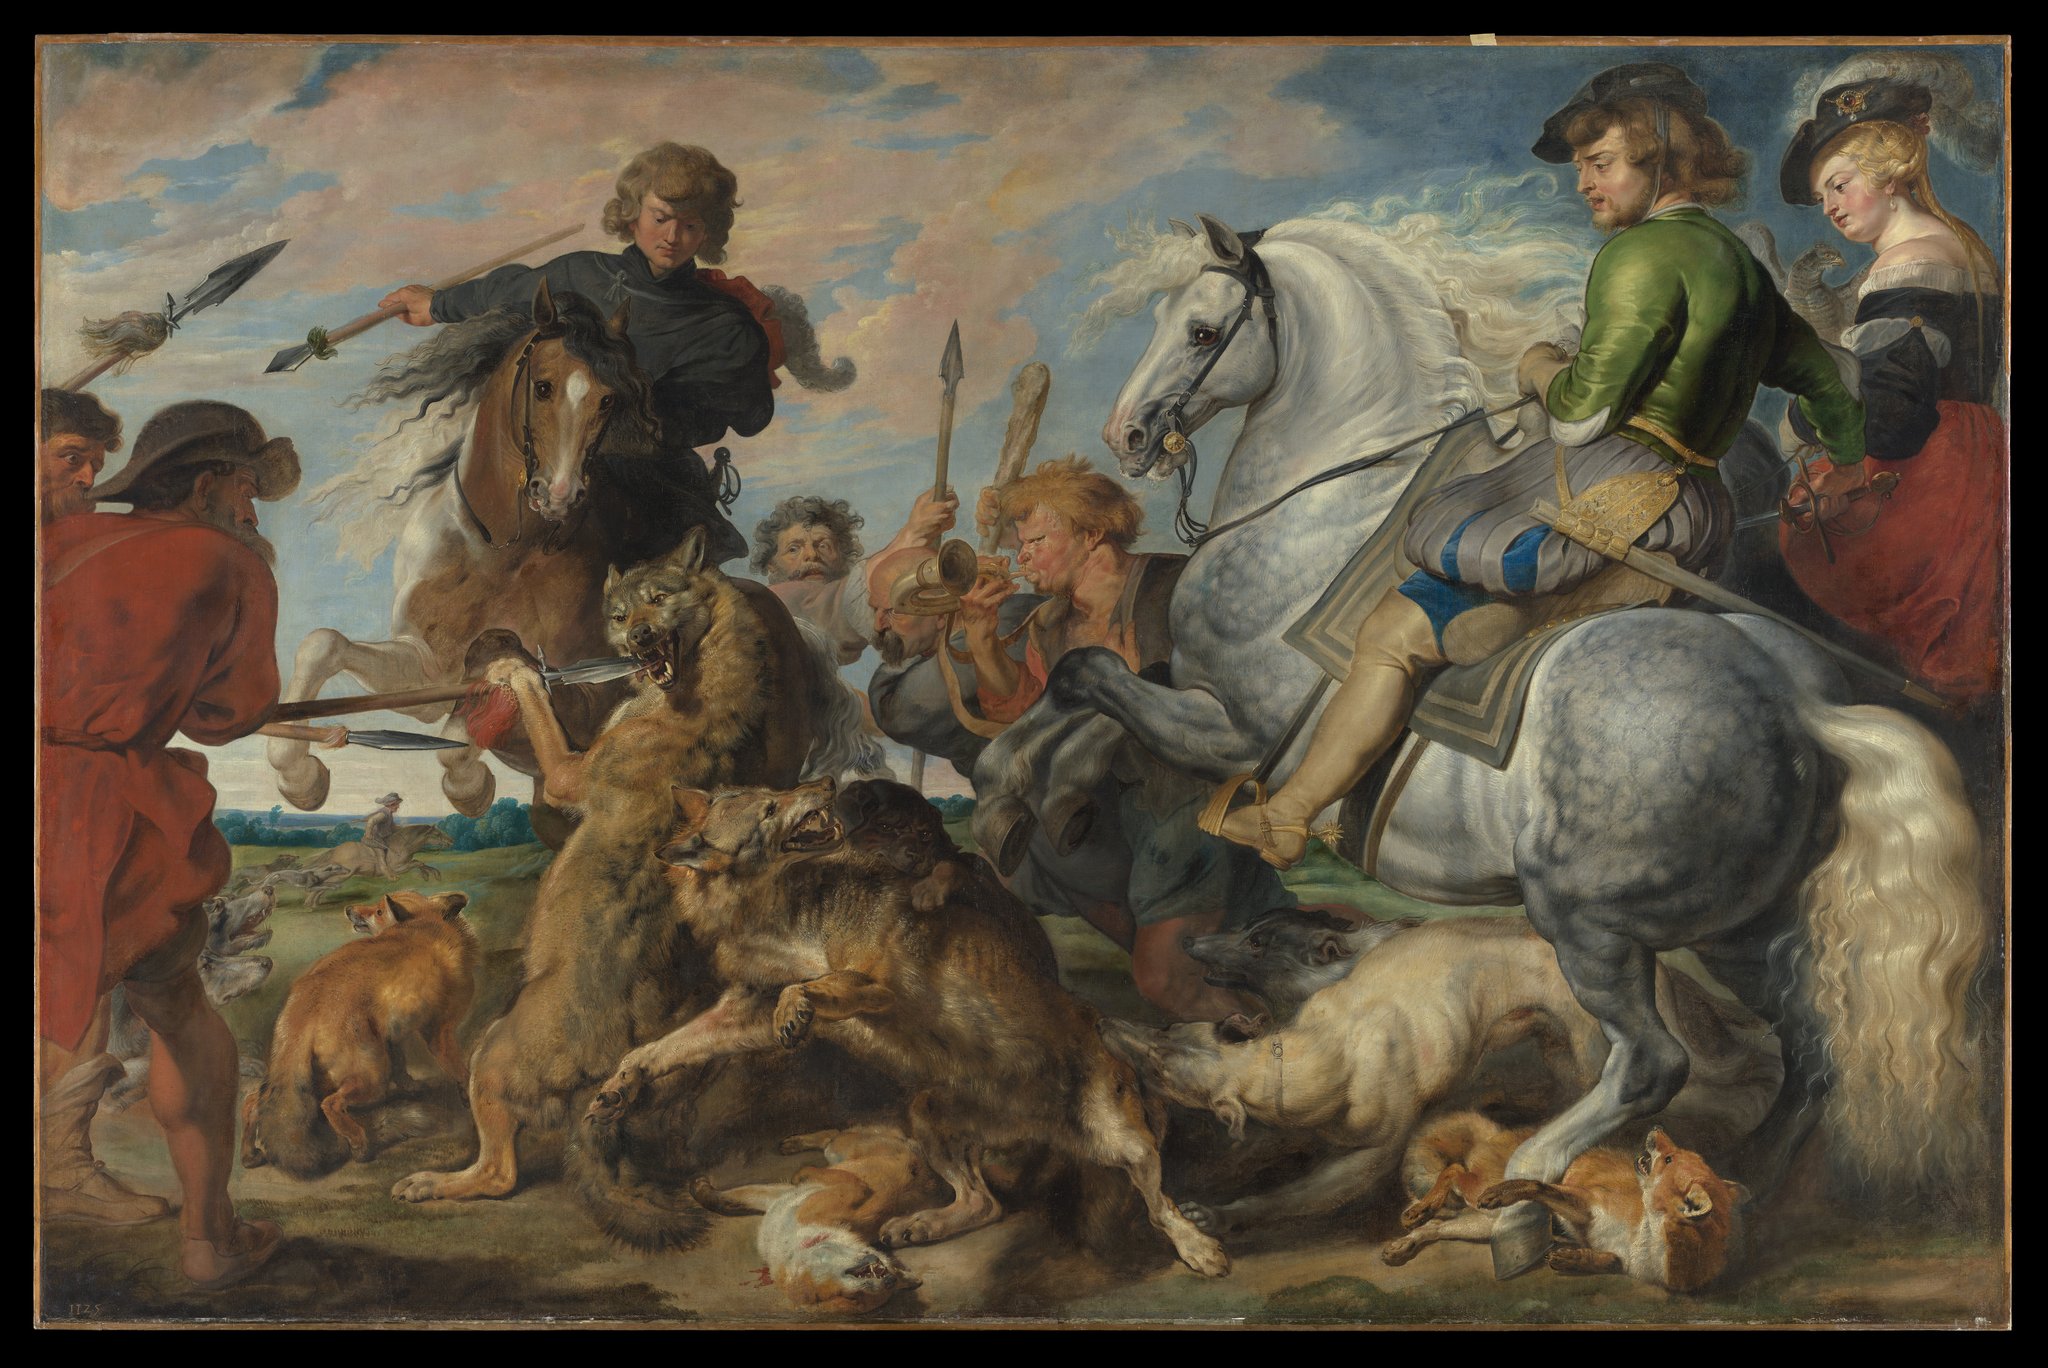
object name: painting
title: Wolf and Fox Hunt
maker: peter paul rubens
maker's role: artist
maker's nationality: flemish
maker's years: 1577-1640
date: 1616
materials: canvas, oil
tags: men,women,hunting,foxes,horses,wolves